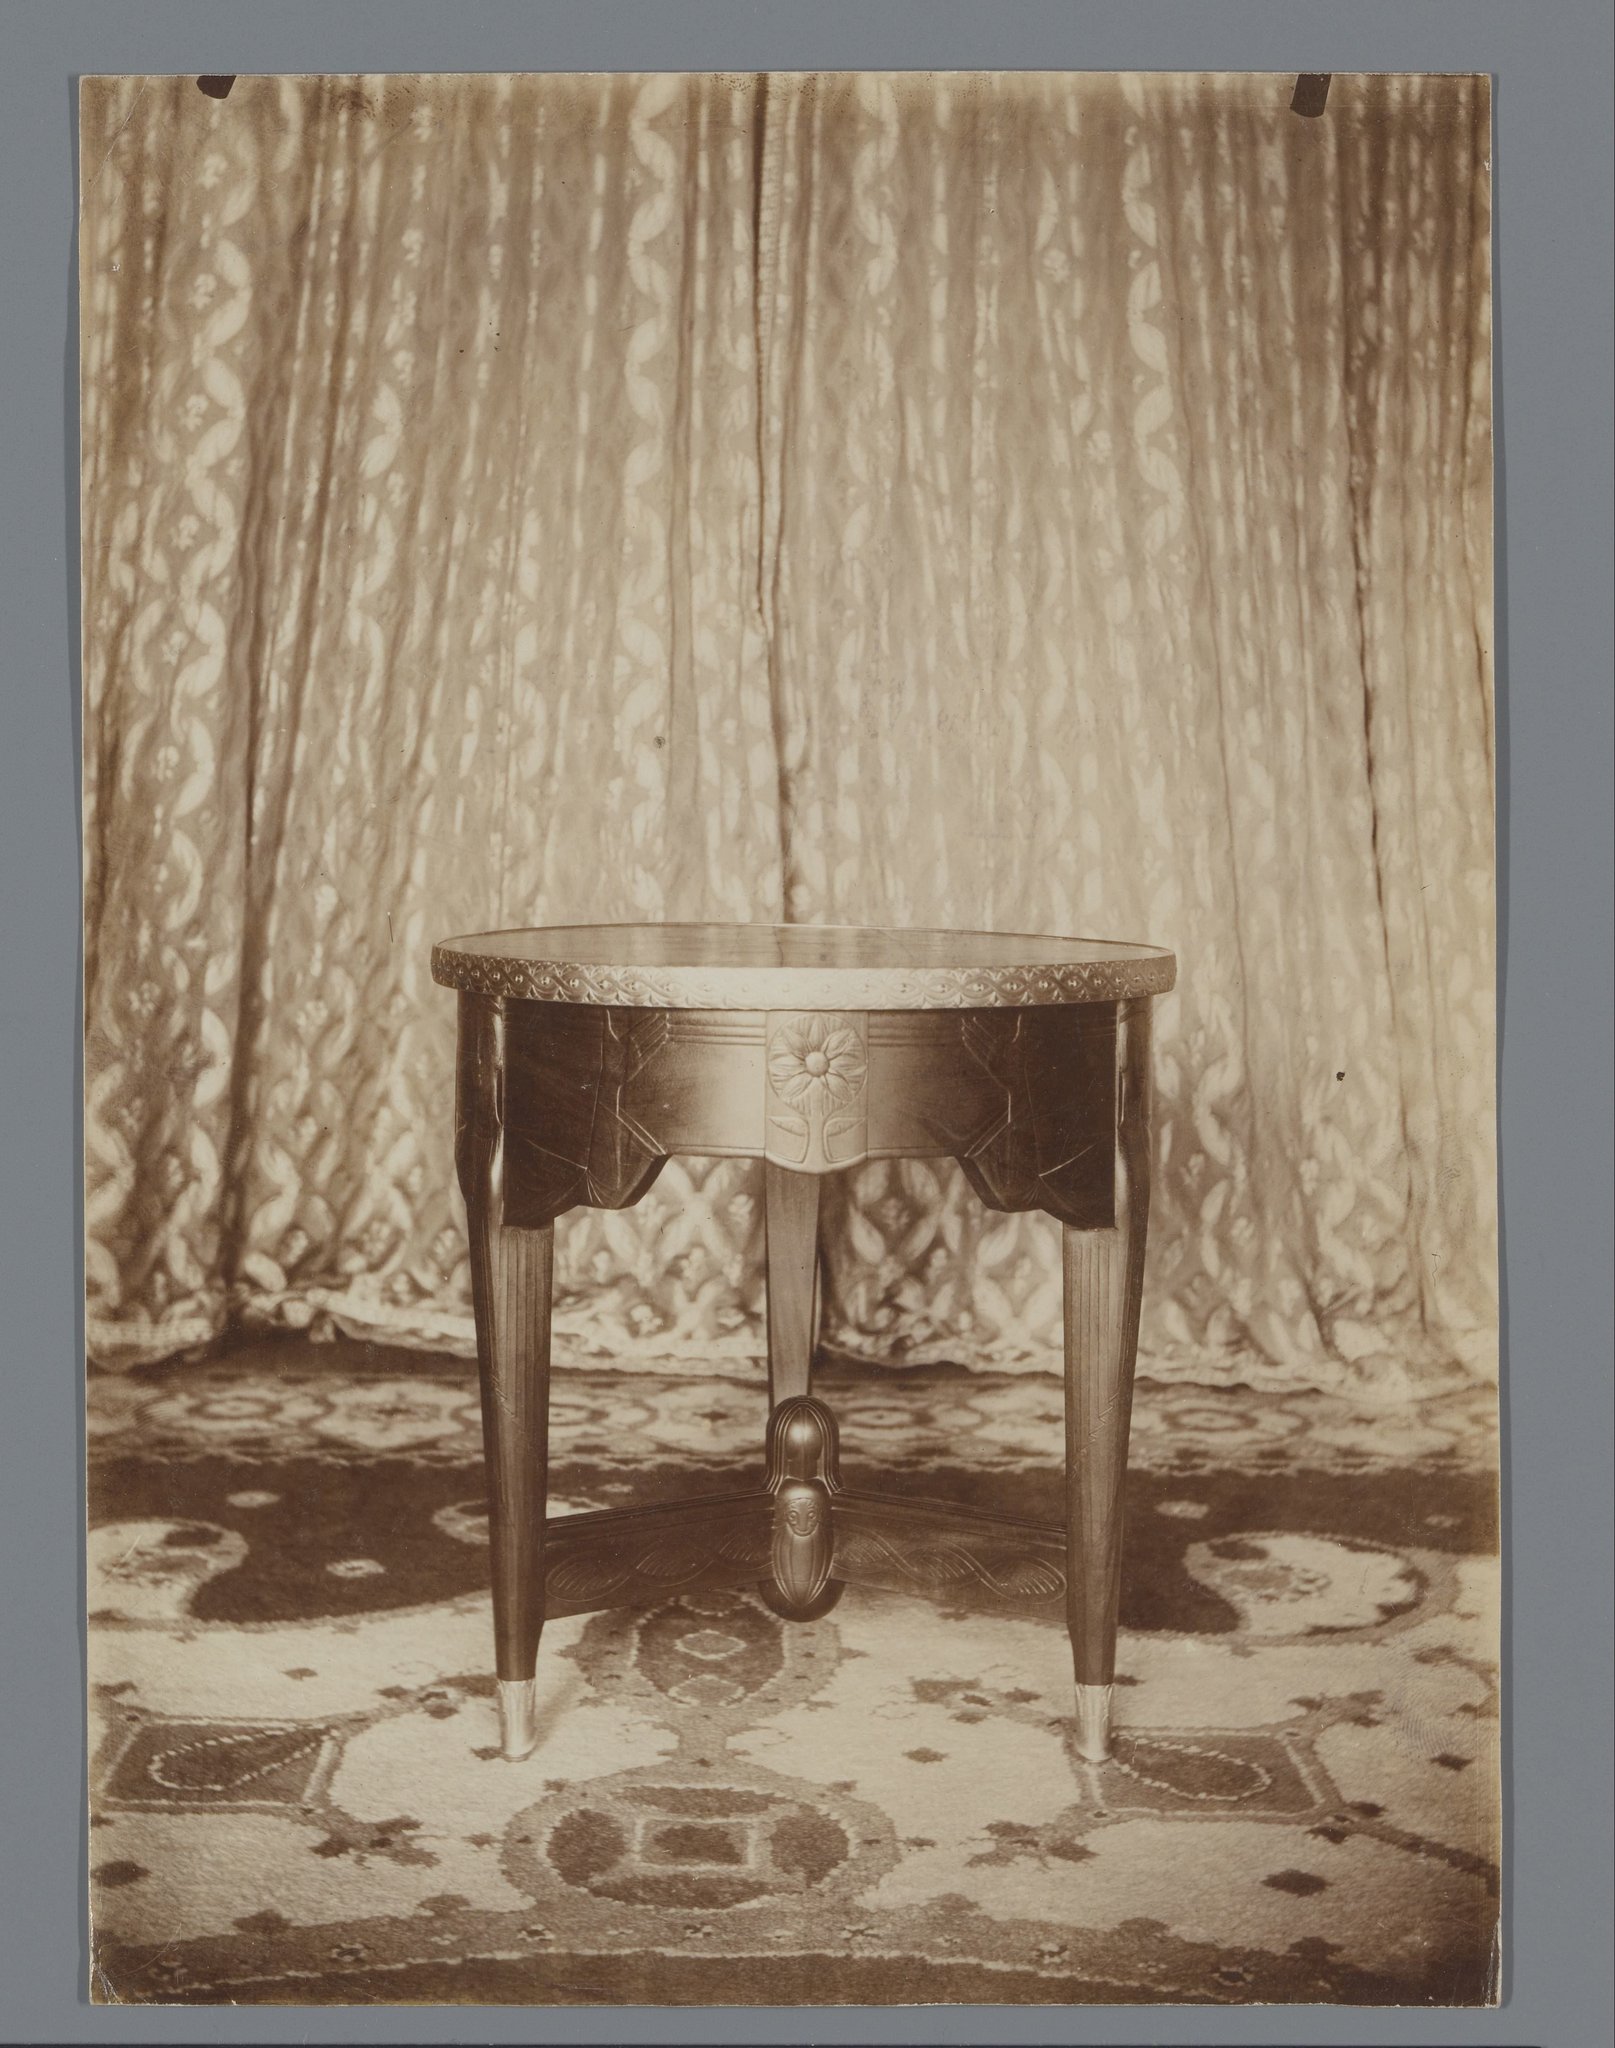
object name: photograph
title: Driepotige tafel naar ontwerp van Mathieu Lauweriks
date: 1910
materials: cardboard, photographic support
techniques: collodion silver print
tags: table (+ wood and other phytogenic material)